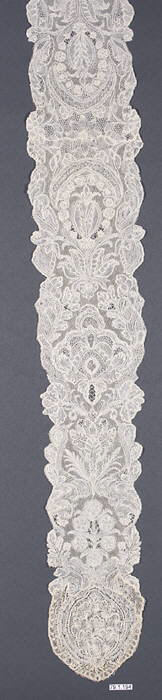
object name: lappet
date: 1700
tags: flowers